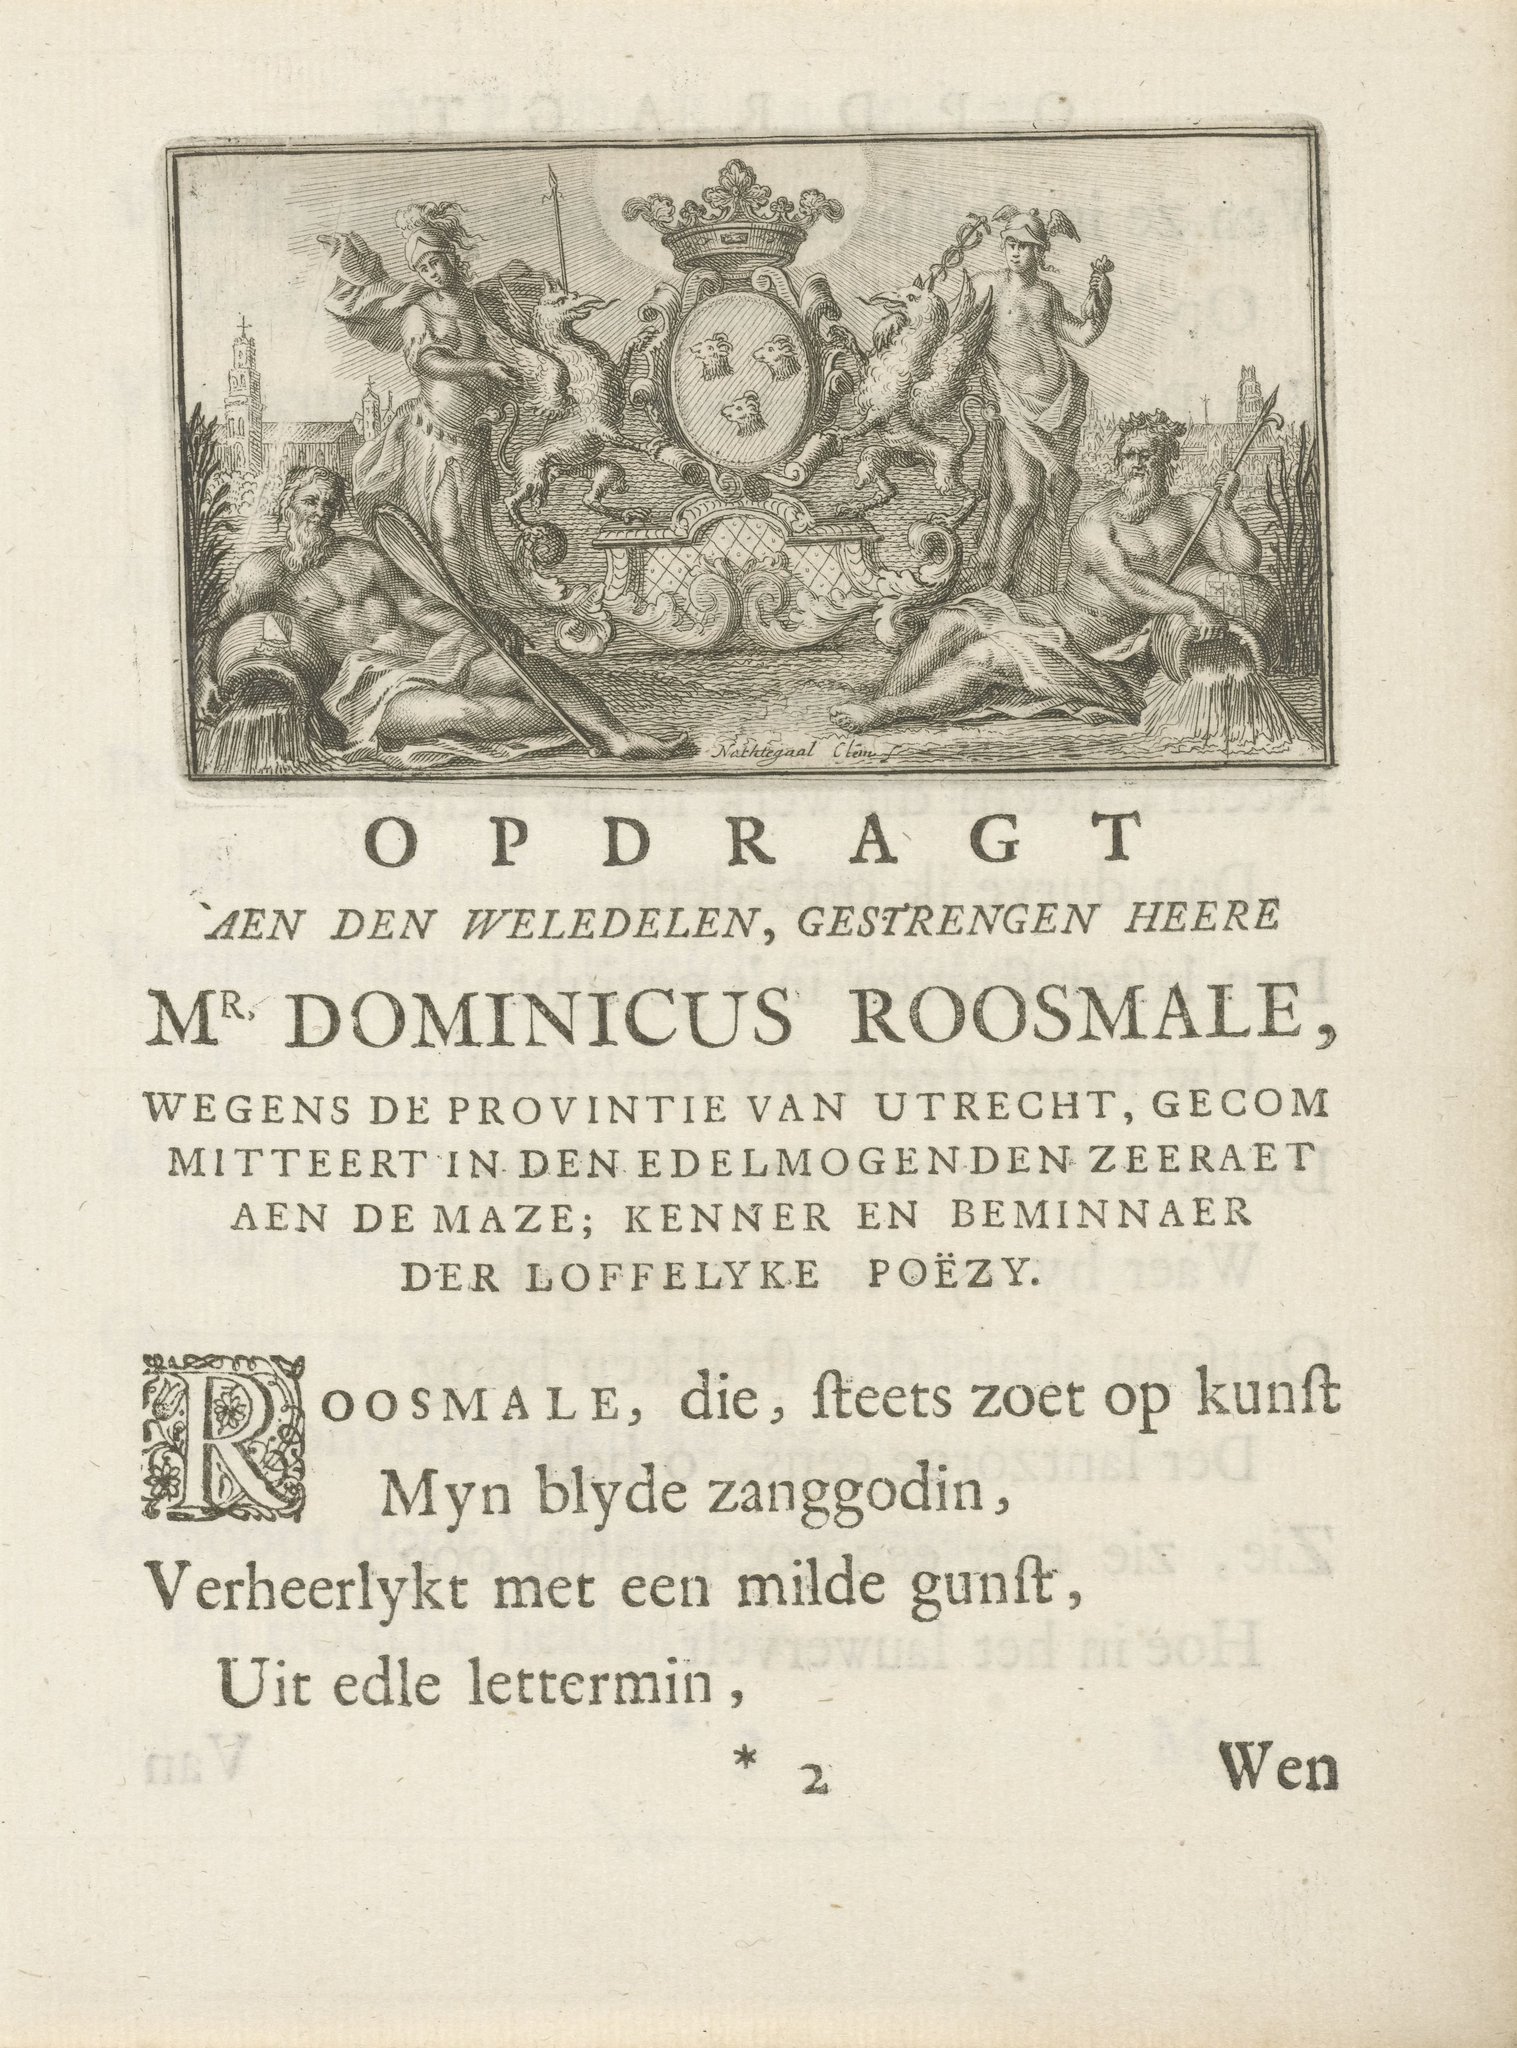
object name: print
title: Minerva en Mercurius met wapenschild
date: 1725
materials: paper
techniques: engraving, etching, letterpress printing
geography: rotterdam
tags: specific aspects, allegorical aspects of minerva; minerva as patroness, specific aspects, allegorical aspects of mercury; mercury as patron, armorial bearing, heraldry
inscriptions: collector's mark: Lugt 2760, collector's mark: Lugt 2228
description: Een gekroond wapenschild met drie geitenkoppen, geflankeerd door Minerva en Mercurius. In de hoeken Tritons, ieder met een kruik waar water uitstroomt. Drie bladen met tekst in boekdruk in het Nederlands op recto en verso.